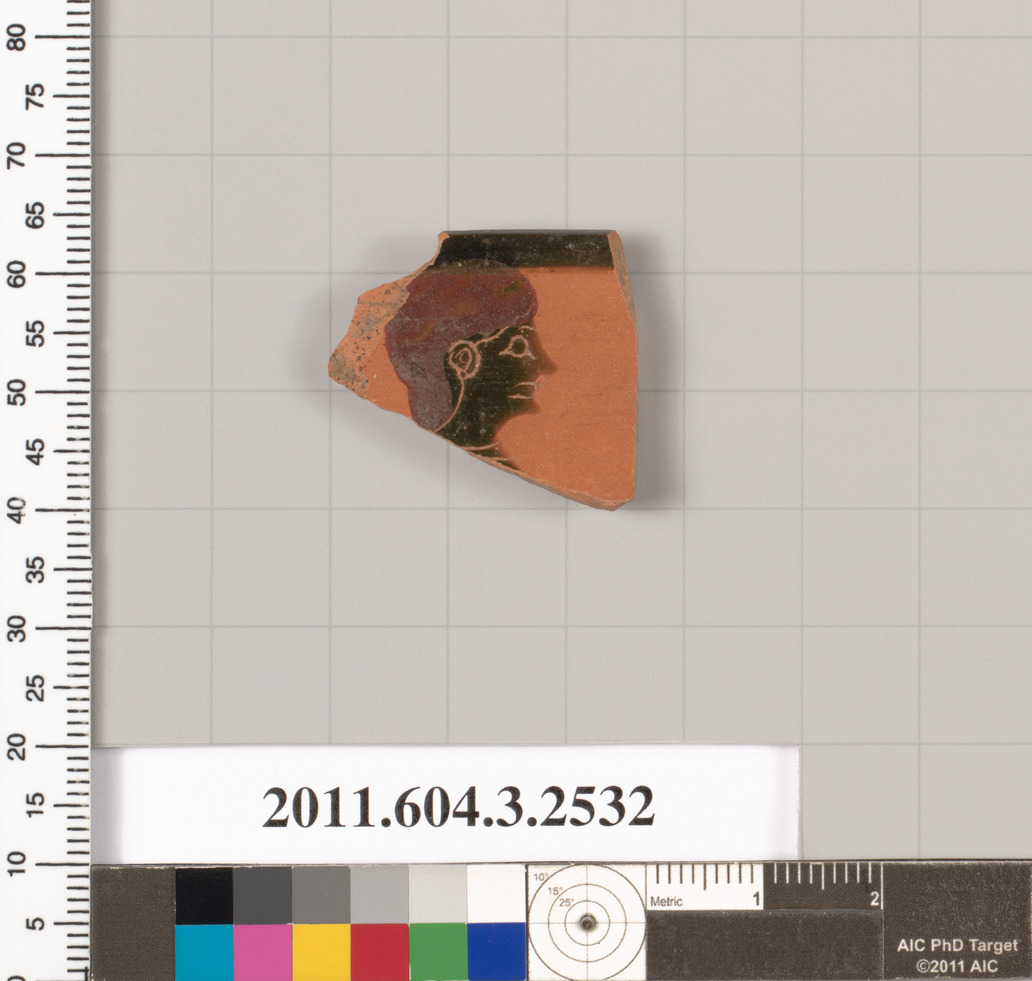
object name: kylix fragment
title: Terracotta rim fragment of a kylix: Siana cup (drinking cup)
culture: greek, attic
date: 550-526 BCE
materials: terracotta